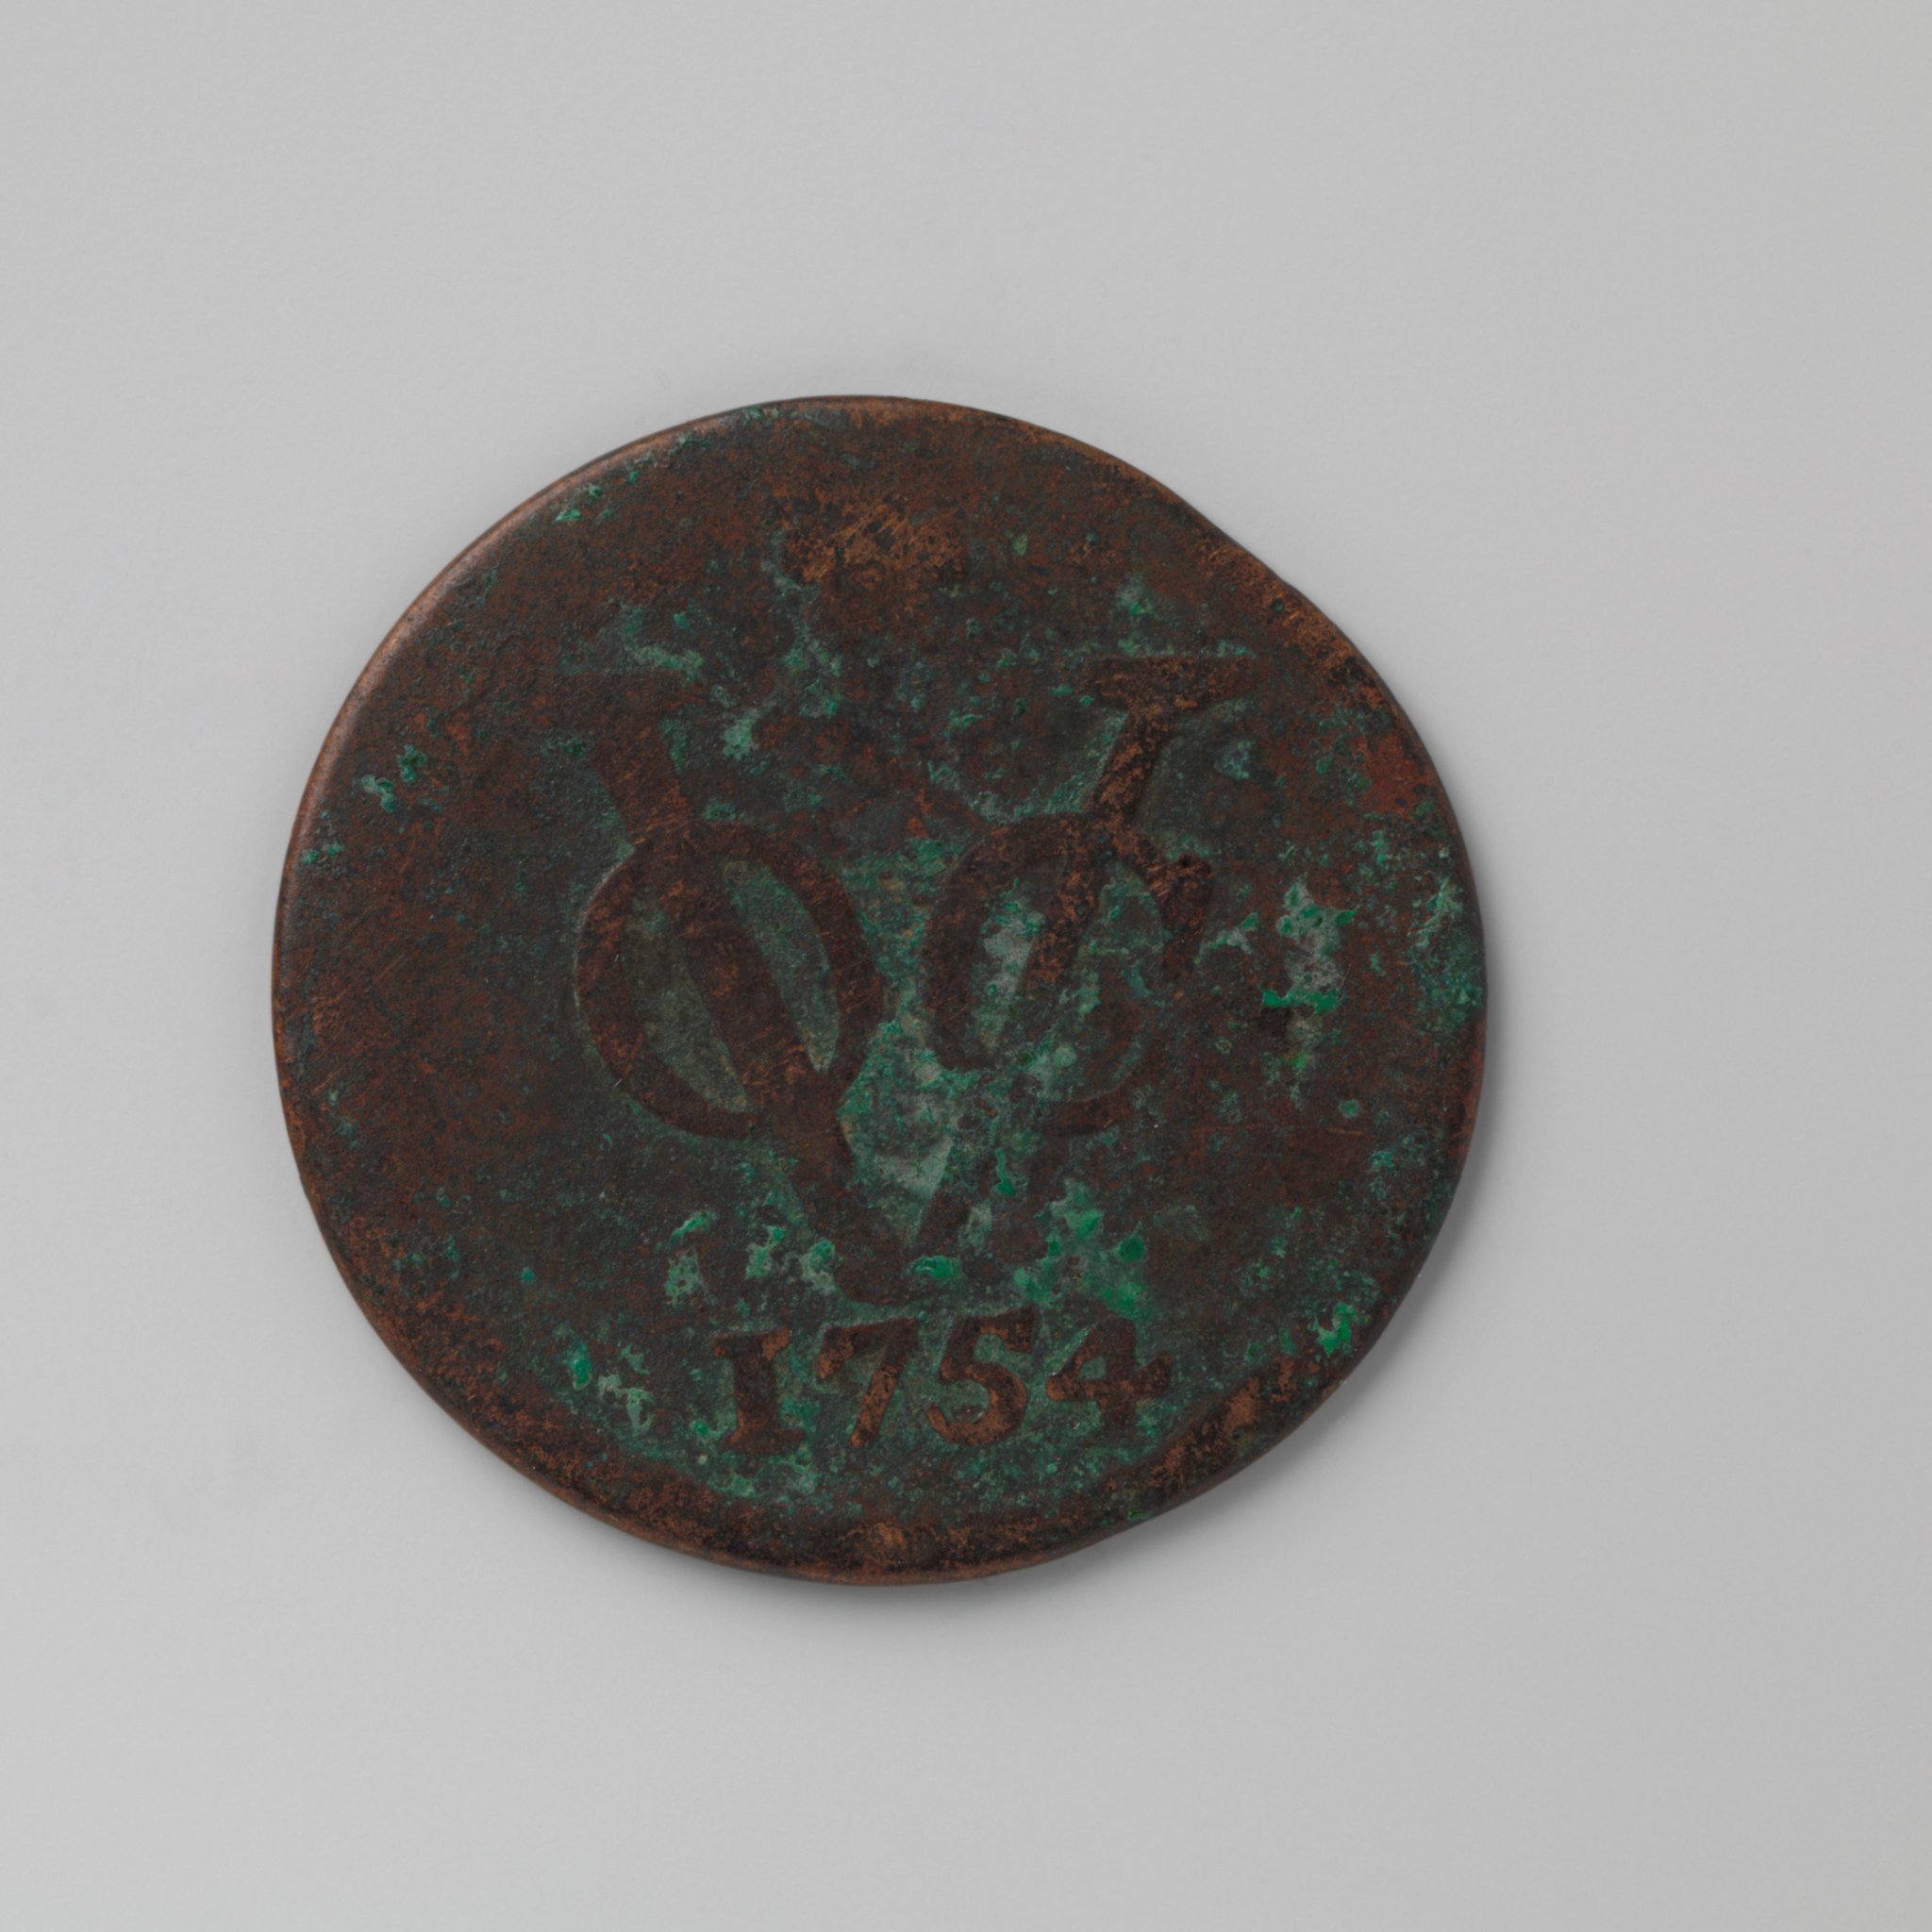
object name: coin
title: Duit van de VOC uit Holland, 1754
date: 1754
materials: copper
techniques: striking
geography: dordrecht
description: Koperen munt. Voorzijde: gekroond wapenschild van Holland. Keerzijde: monogram van de VOC, waarboven muntteken en waaronder jaartal. Gladde rand.